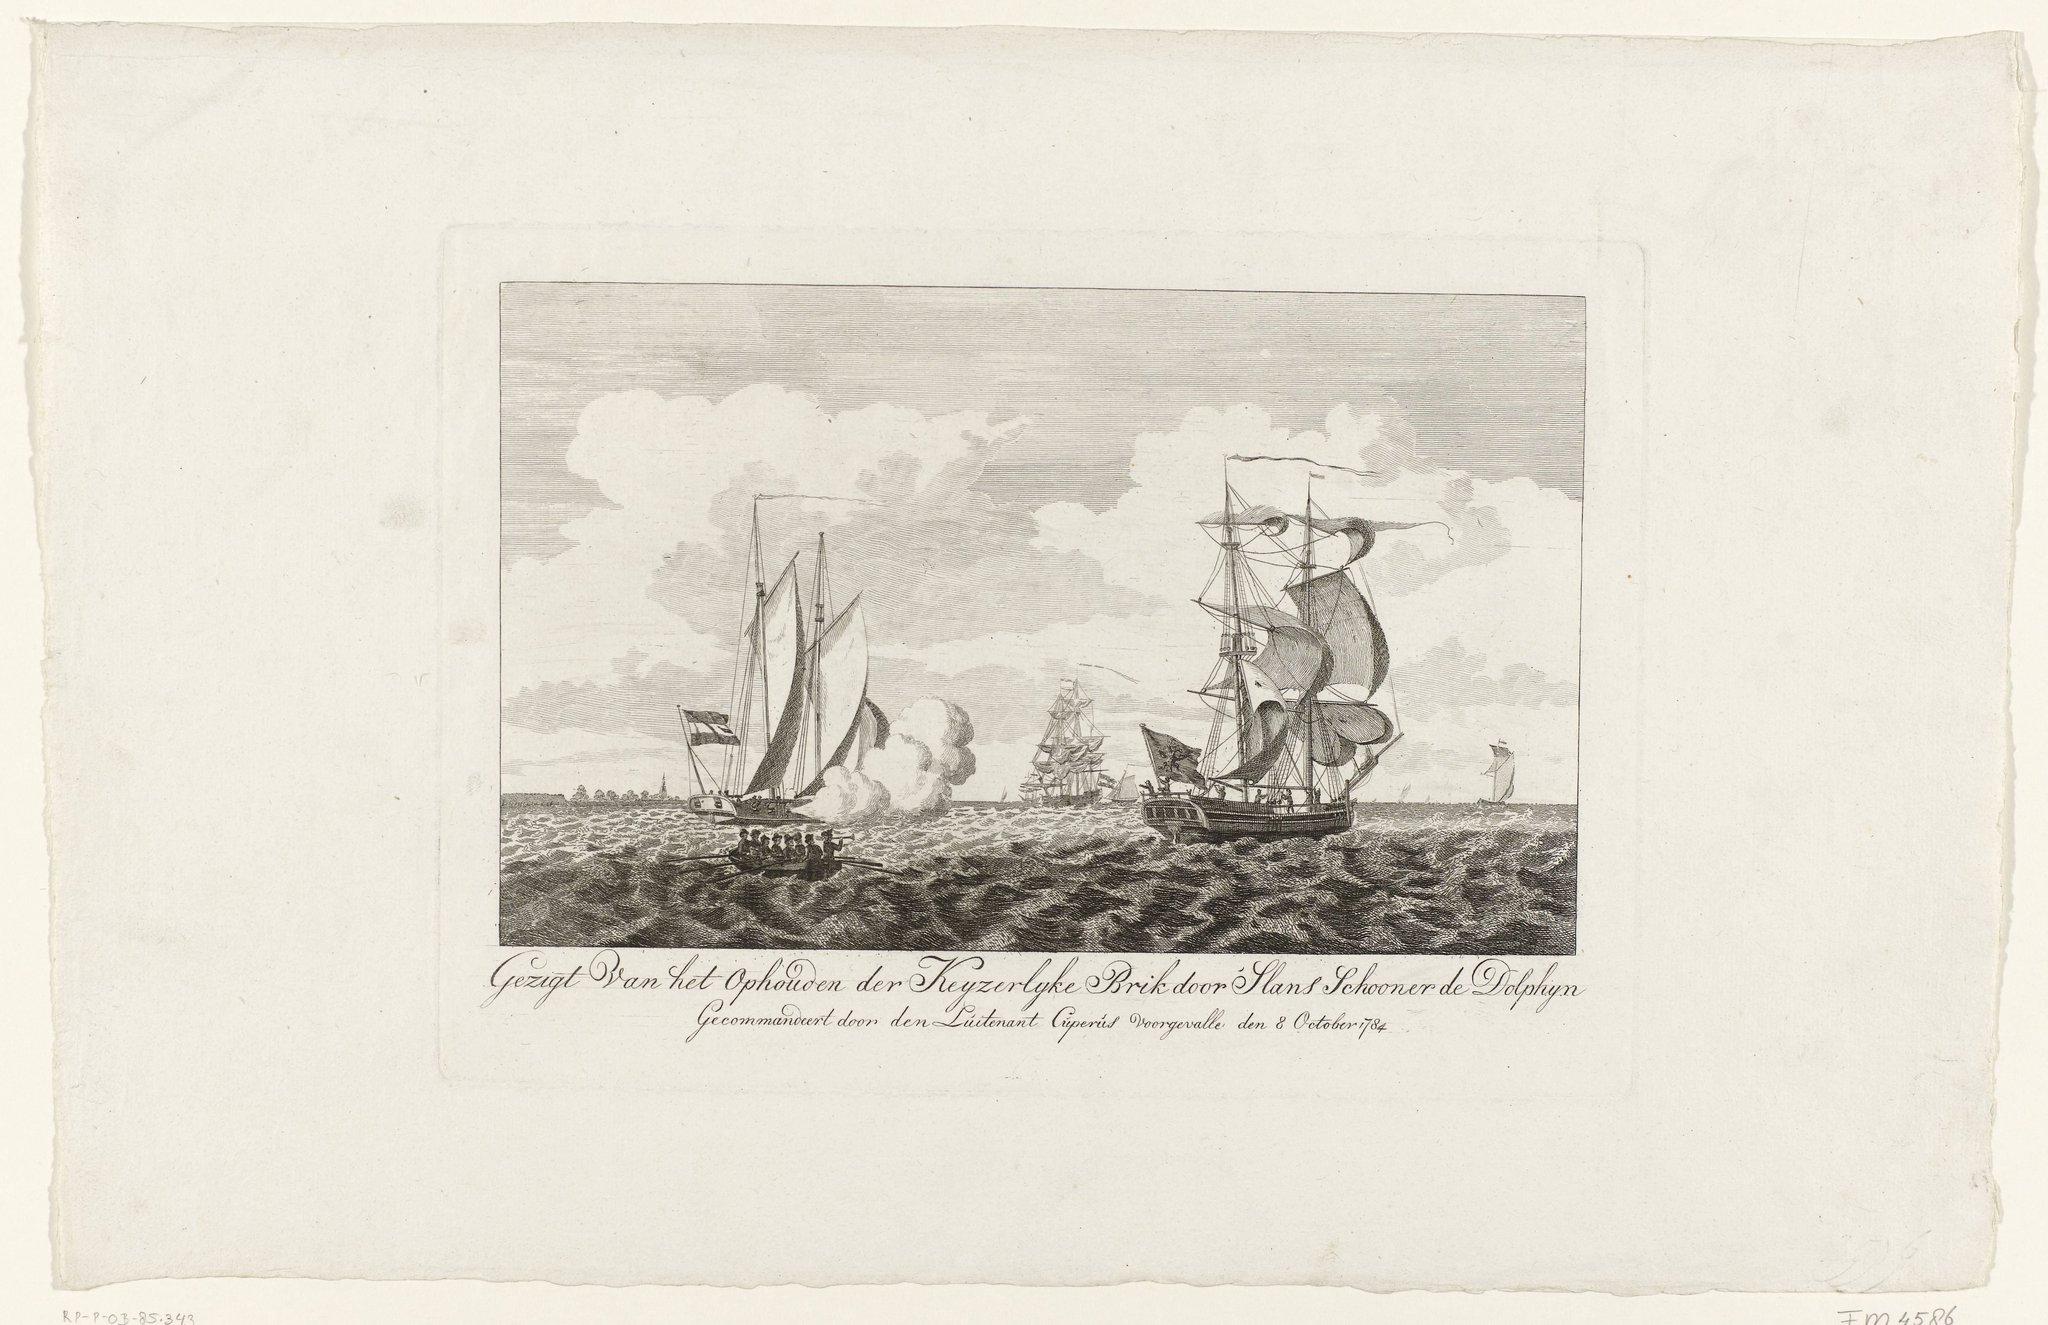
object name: print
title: Ophouden van de keizerlijke brik op de Schelde, 1784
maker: Anonymous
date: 1784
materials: paper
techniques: engraving, etching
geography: northern netherlands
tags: battle (+ sailing-ships)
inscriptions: collector's mark: Lugt 2228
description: Het ophouden van de Oostenrijkse keizerlijke brik door de Nederlandse schoener de Dolphijn onder commando van luitenant Tobias Tak Cuperus op de Schelde, 8 oktober 1784. Het Nederlandse schip vuurt een waarschuwingsschot terwijl de bemanning van de brik vanuit een sloep met een scheepsroeper wordt toegesproken. De incidenten op deze dag worden aangeduid met de spotnaam de Keteloorlog.